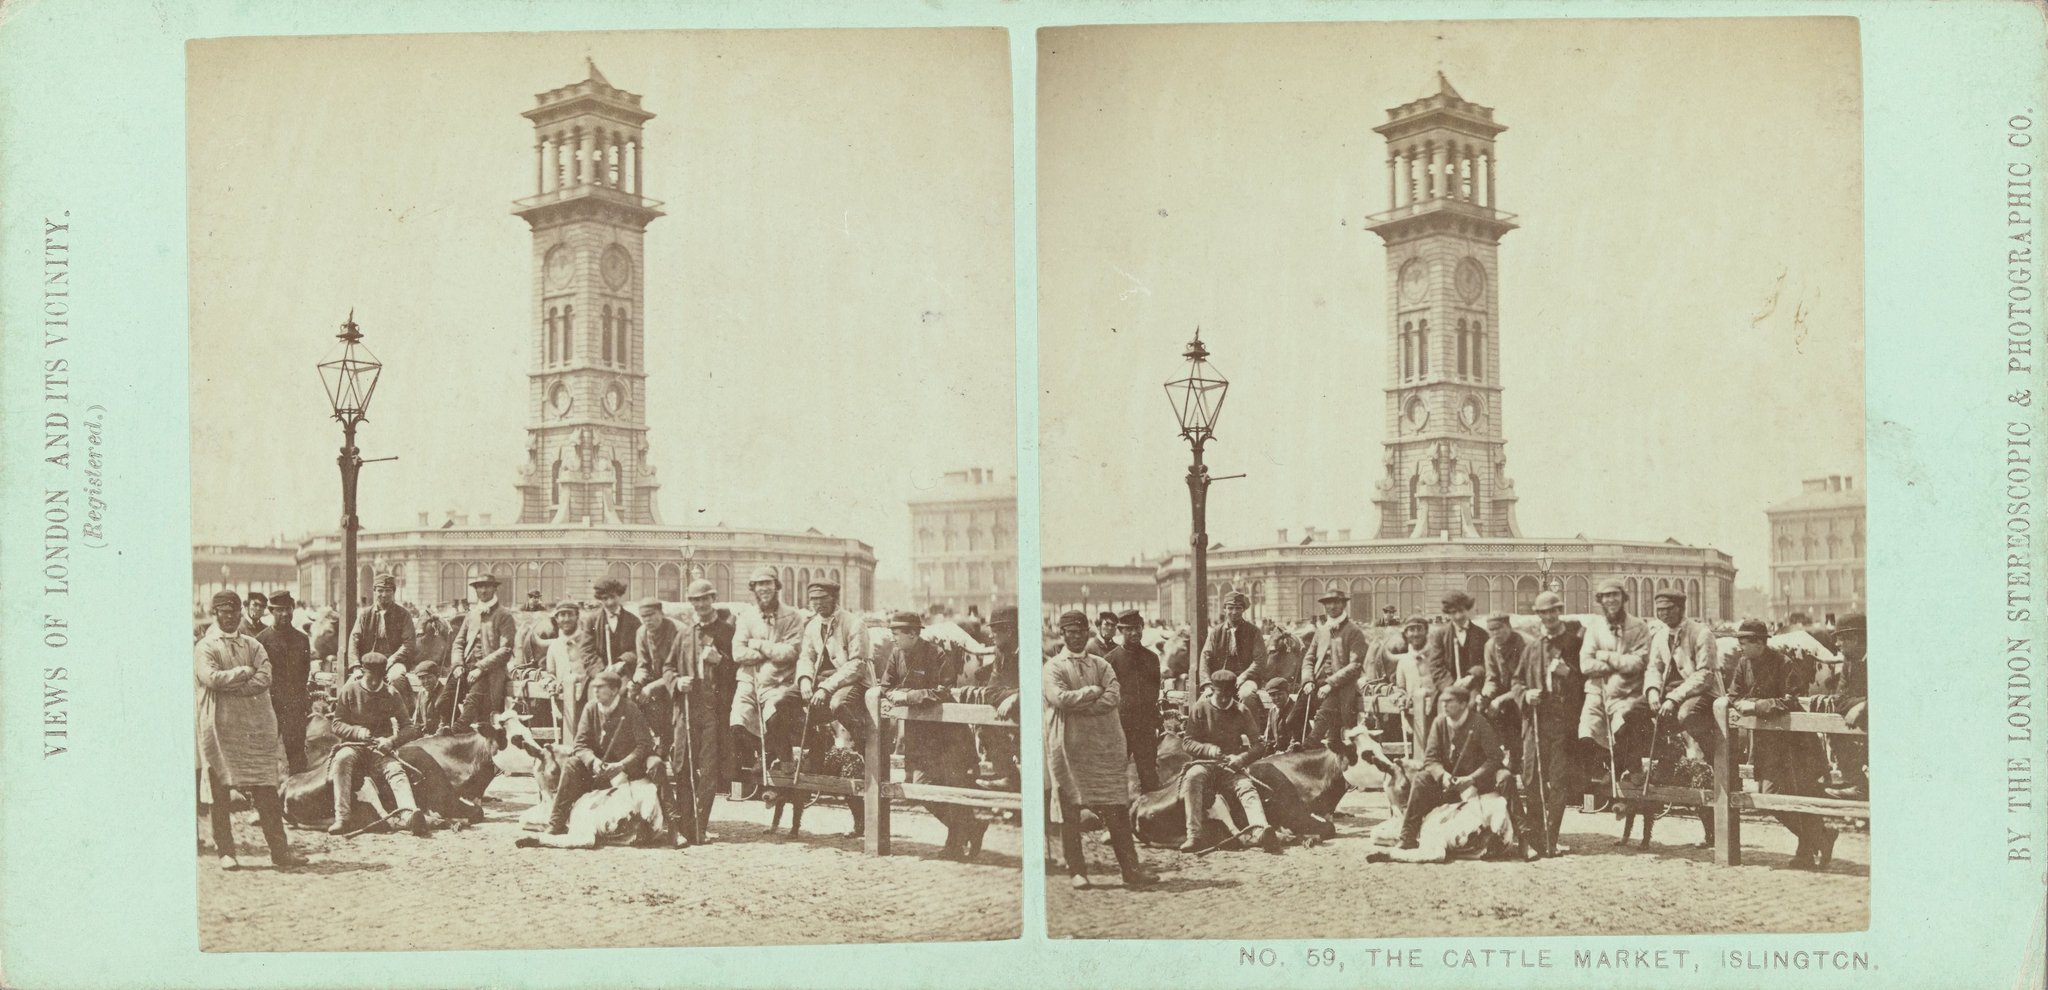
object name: stereograph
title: Veemarkt in Islington met op de achtergrond de Caledonian Park Clock Tower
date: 1860-1880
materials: cardboard, paper, photographic support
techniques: albumen print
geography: islington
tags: tower, clock tower ~ monumental adornment, market